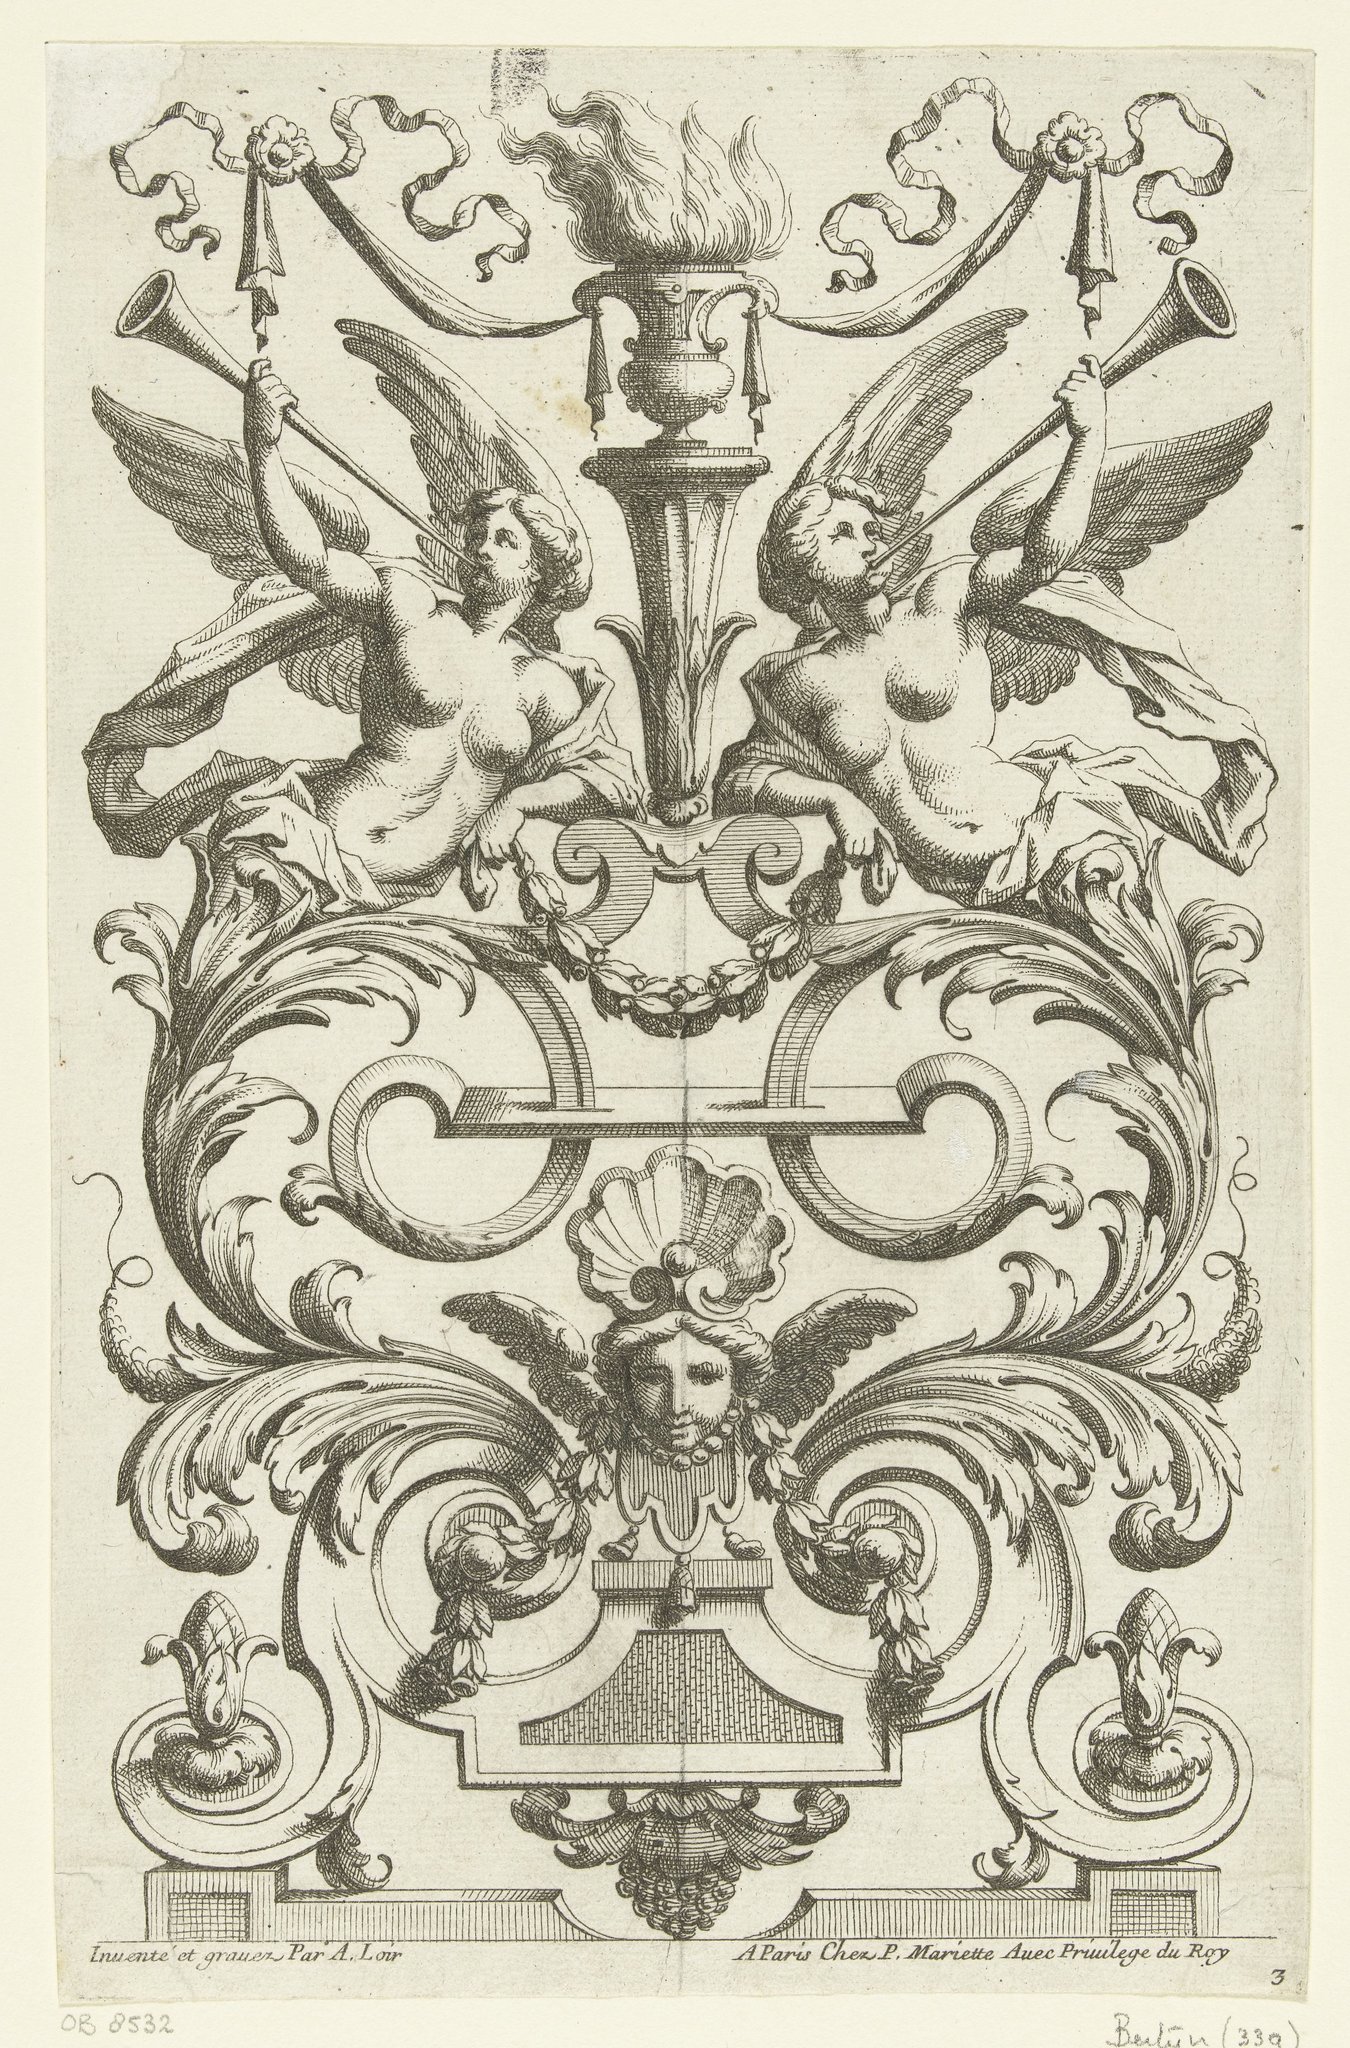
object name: print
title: Panaux Dornements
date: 1670-1690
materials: paper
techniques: etching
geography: paris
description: Beide vrouwen ontspruiten uit een bladrank en blazen op een trompet.